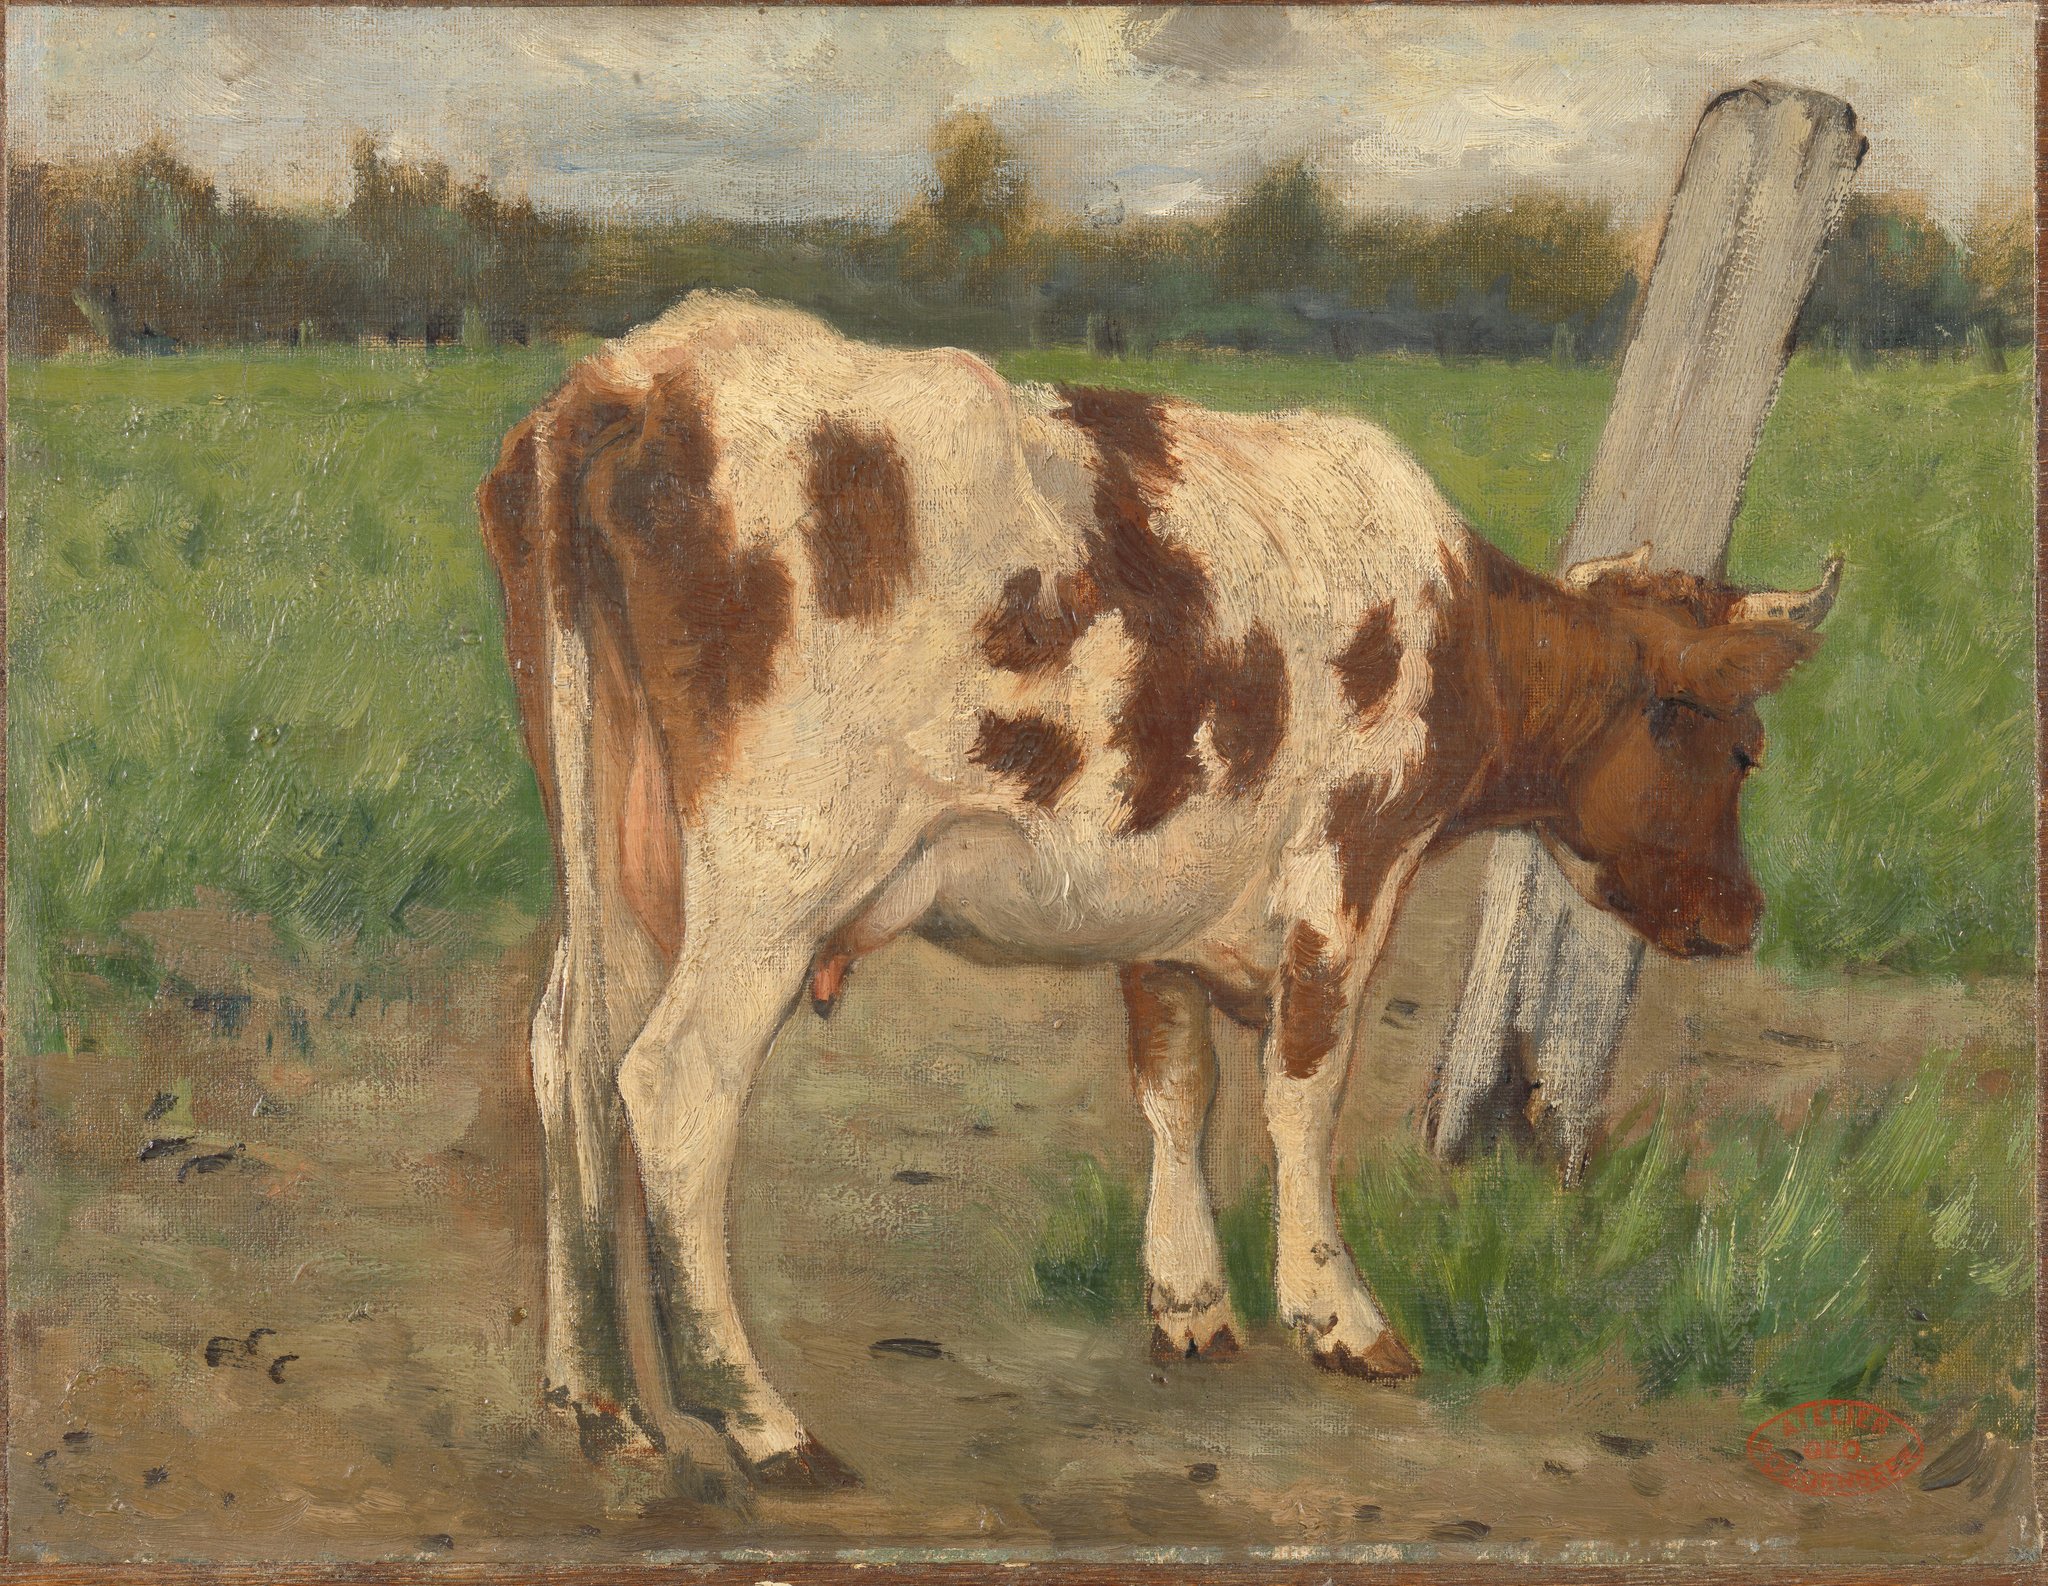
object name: painting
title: Cow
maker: geo poggenbeek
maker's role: draughtsman, painter, print maker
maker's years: 1853-1903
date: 1873-1903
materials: canvas, oil, panel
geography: netherlands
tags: cow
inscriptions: workshop stamp: ‘Atelier Geo. Poggenbeek’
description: Studie van een bonte koe, staande bij een paal in een weide.